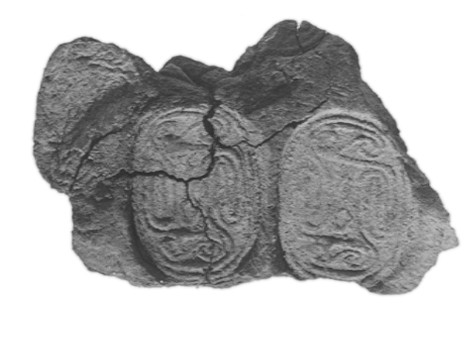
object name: sealing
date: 2030-1640 BCE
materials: clay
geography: egypt